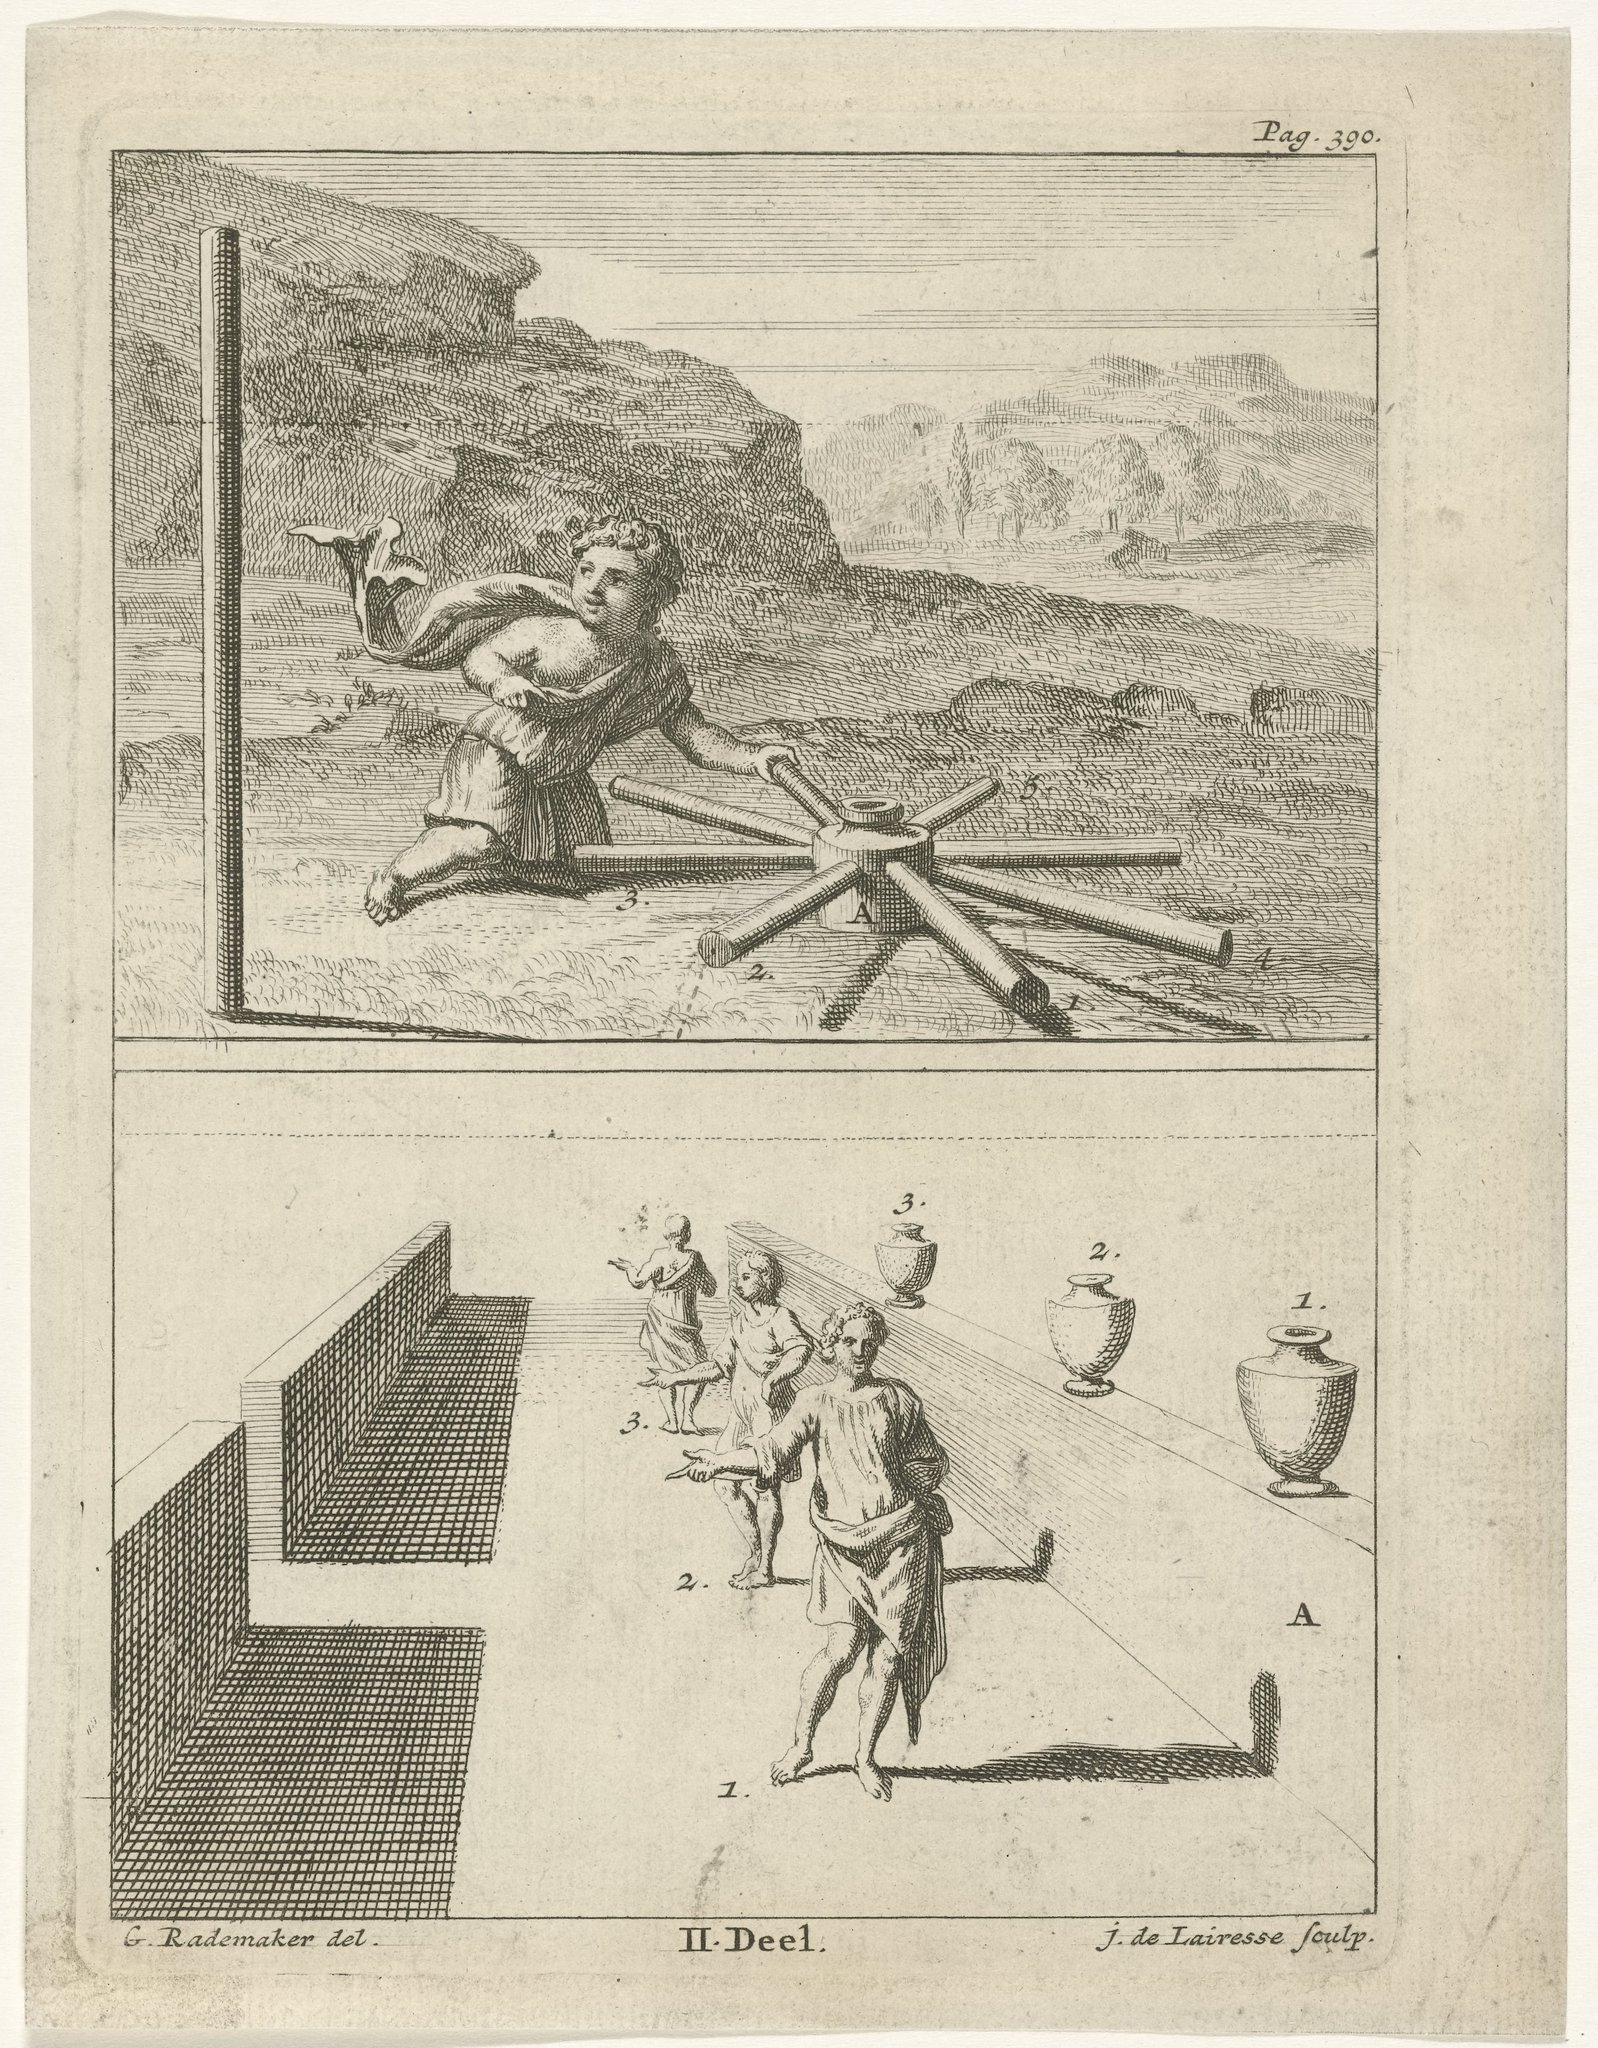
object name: print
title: Jongen geknield bij de spaken van een wiel en een perspectiefstudie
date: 1707-1740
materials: paper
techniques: etching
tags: spokes, mathematical perspective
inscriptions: collector's mark: Lugt 2760, collector's mark: Lugt 2228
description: Twee voorstellingen van één plaat. Boven: Een jongen bestudeert in de natuur de spaken van een wiel. Onder: Perspectiefstudie met vazen en figuren. Specifieke onderdelen in de voorstellingen zijn genummerd of voorzien van de letter A.